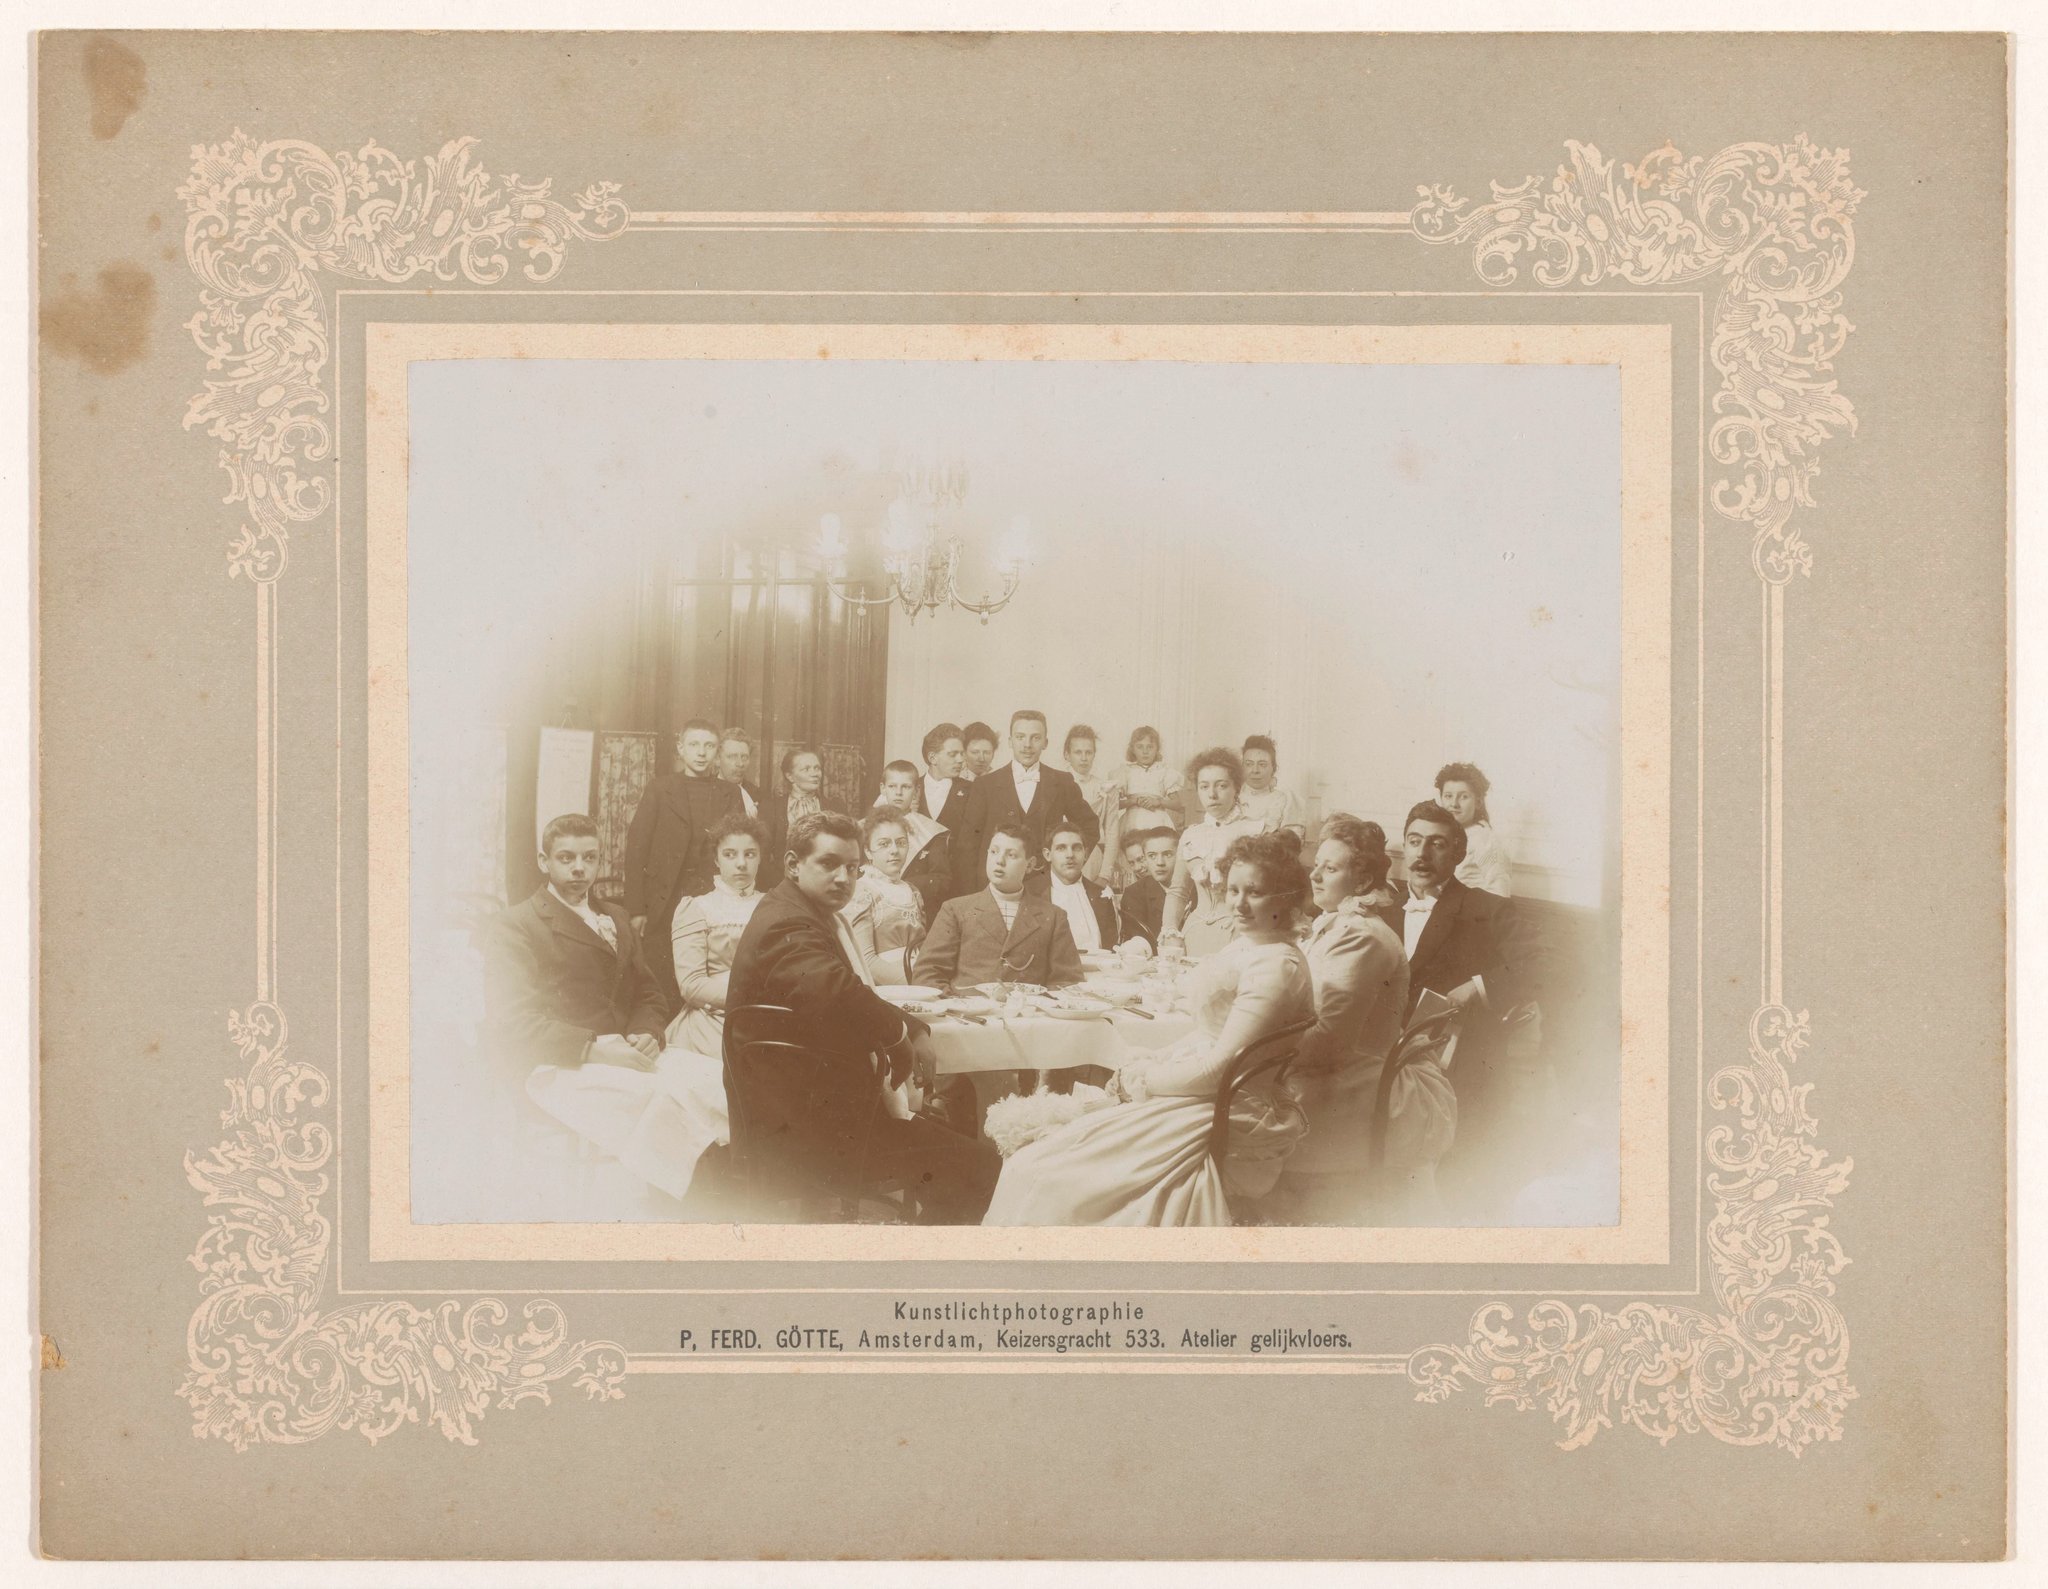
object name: photograph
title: Groepsportret van een gezelschap rond een tafel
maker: paul ferdinand götte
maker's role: fotograaf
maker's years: 1867-1931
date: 1899-1910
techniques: collodion silver print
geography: amsterdam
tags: anonymous historical persons portrayed in a group, in a group-portrait, netherlands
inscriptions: signature: ‘Kunstlichtphotographie P. Ferd. Gotte, Amsterdam, Keizersgracht 533. Atelier gelijkvloers’, stamp: ‘P.F. Gotte, Keizersgracht No. 533 Amsterdam Atelier Parterre. Kunstlichtphotogaphie, bekroond met Goud 1899’